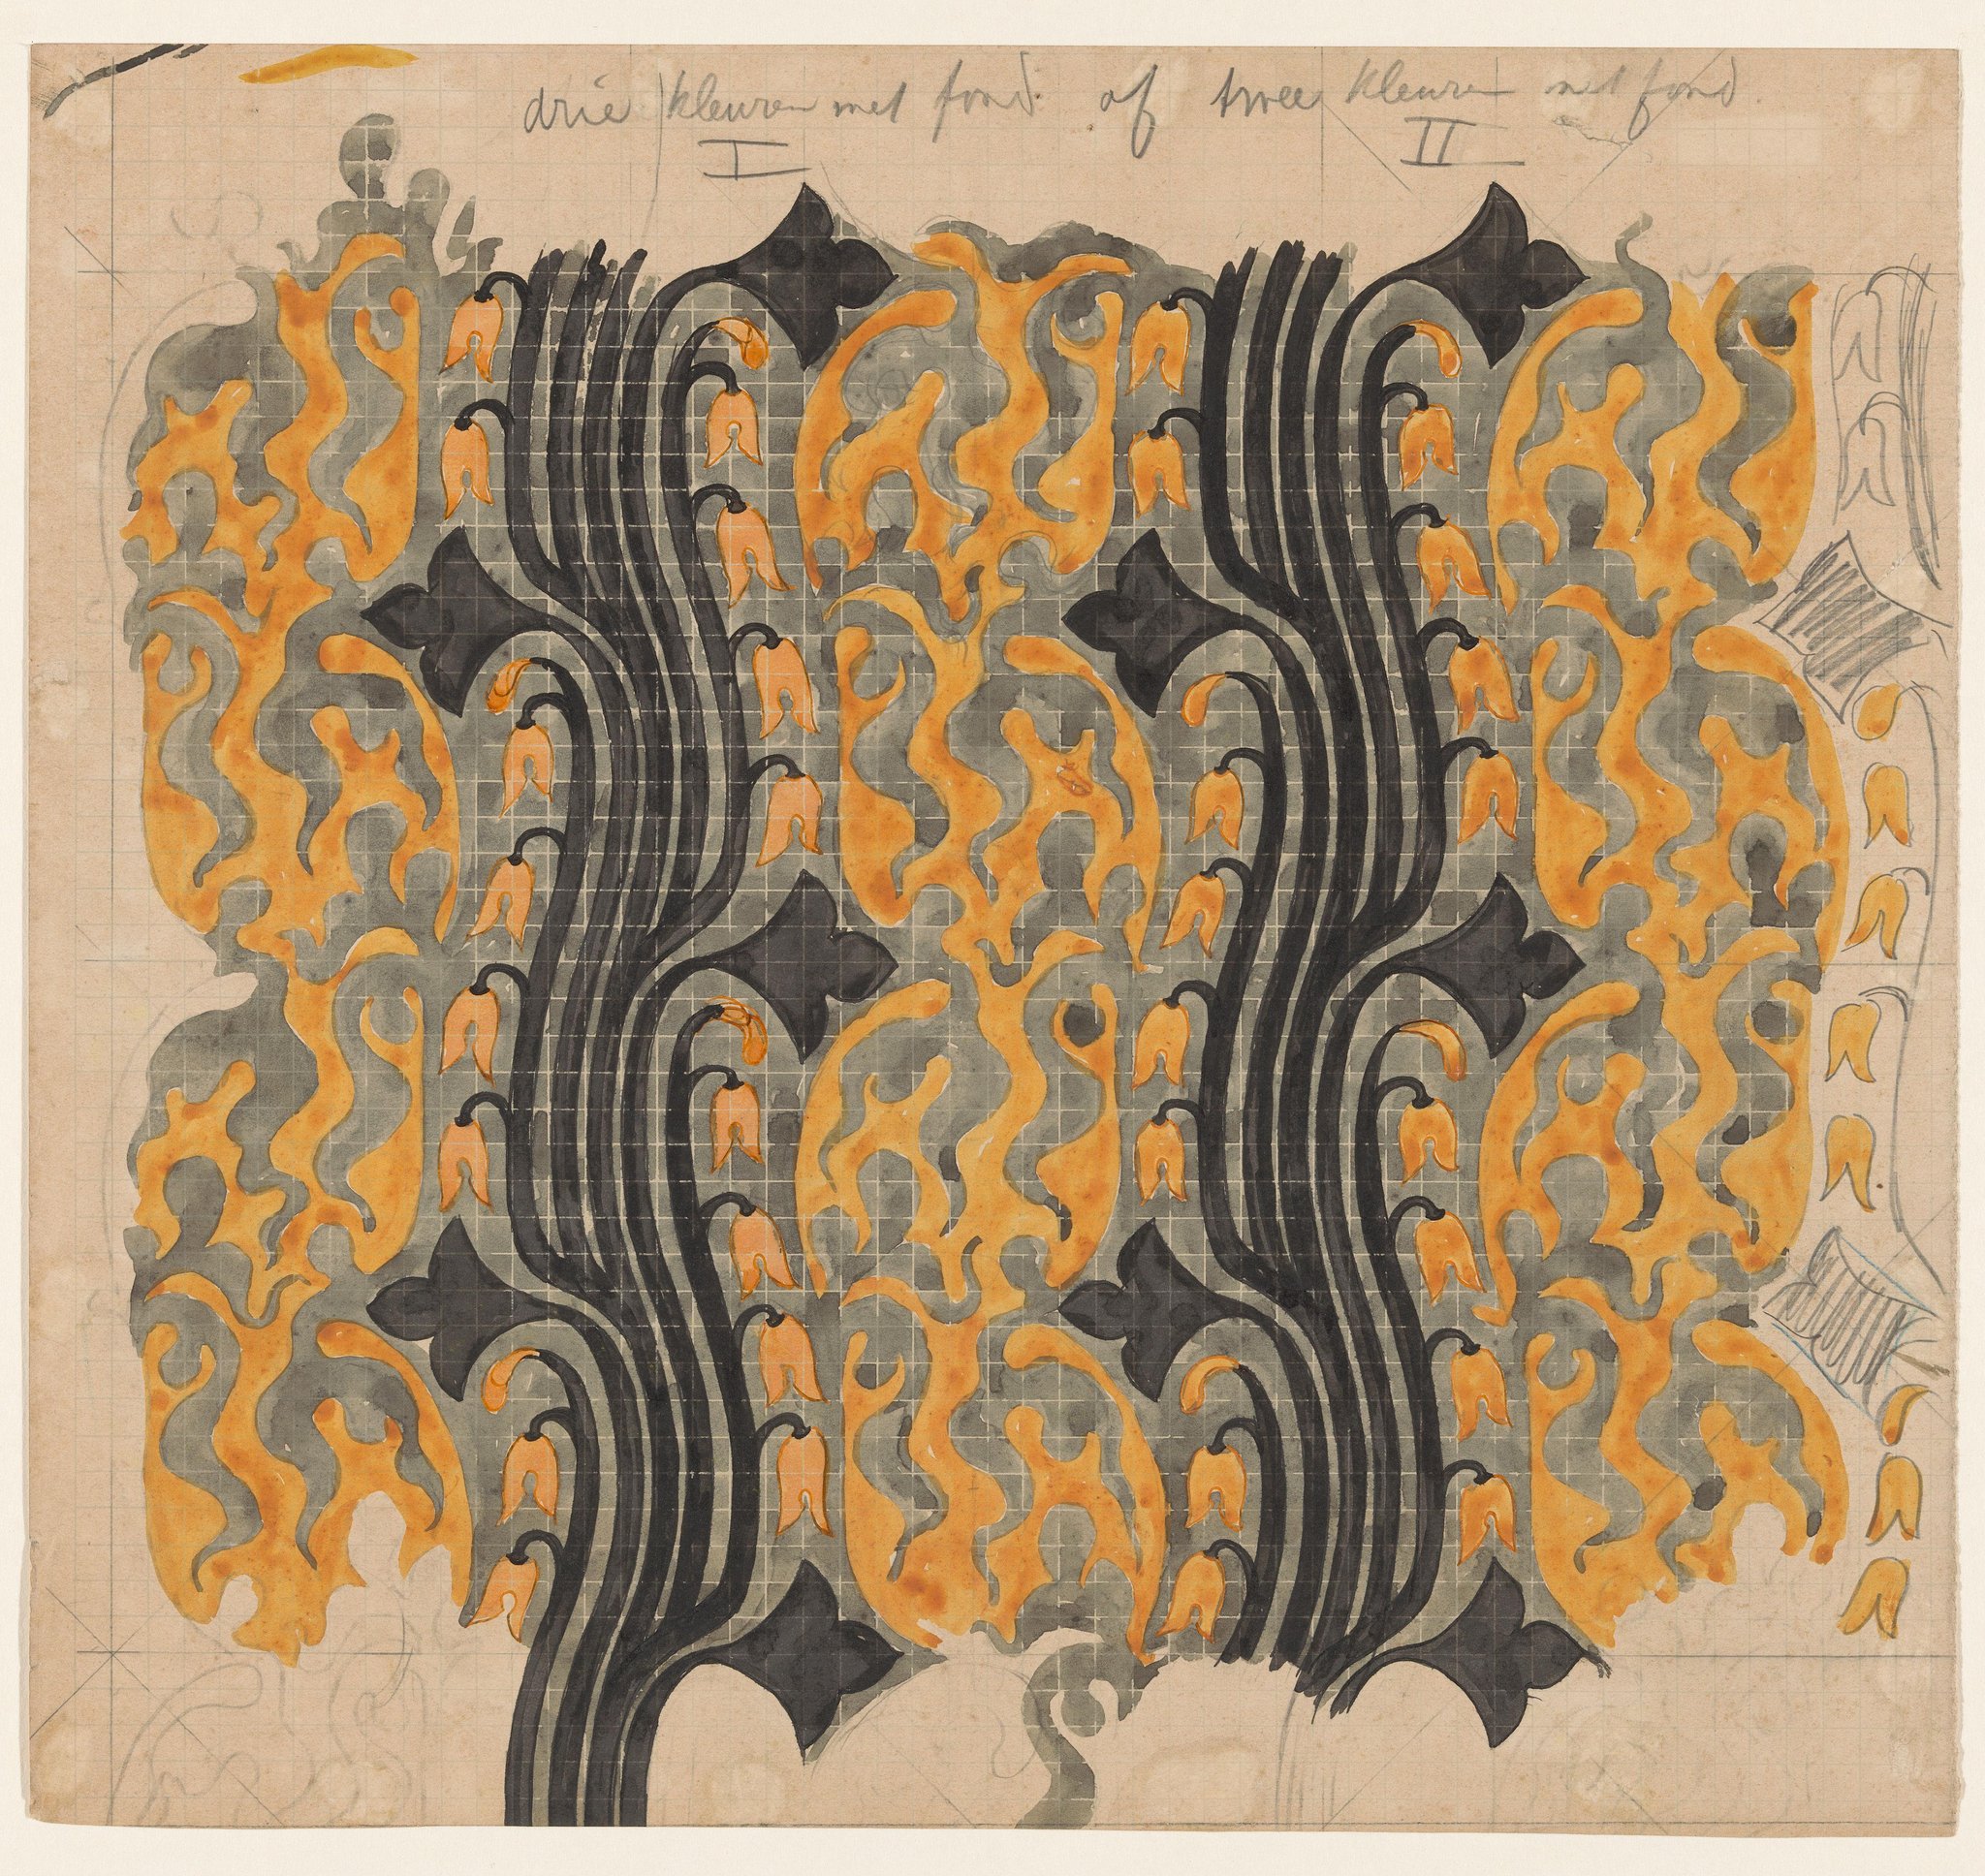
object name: drawing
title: Decoratief ornament met golven en bloemen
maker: roelf gerbrands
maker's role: designer, draughtsman, print maker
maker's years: 1891-1954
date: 1901-1954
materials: ink, pencil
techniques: brush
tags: foliage ~ ornament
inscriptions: :, collector's mark: Lugt 2228